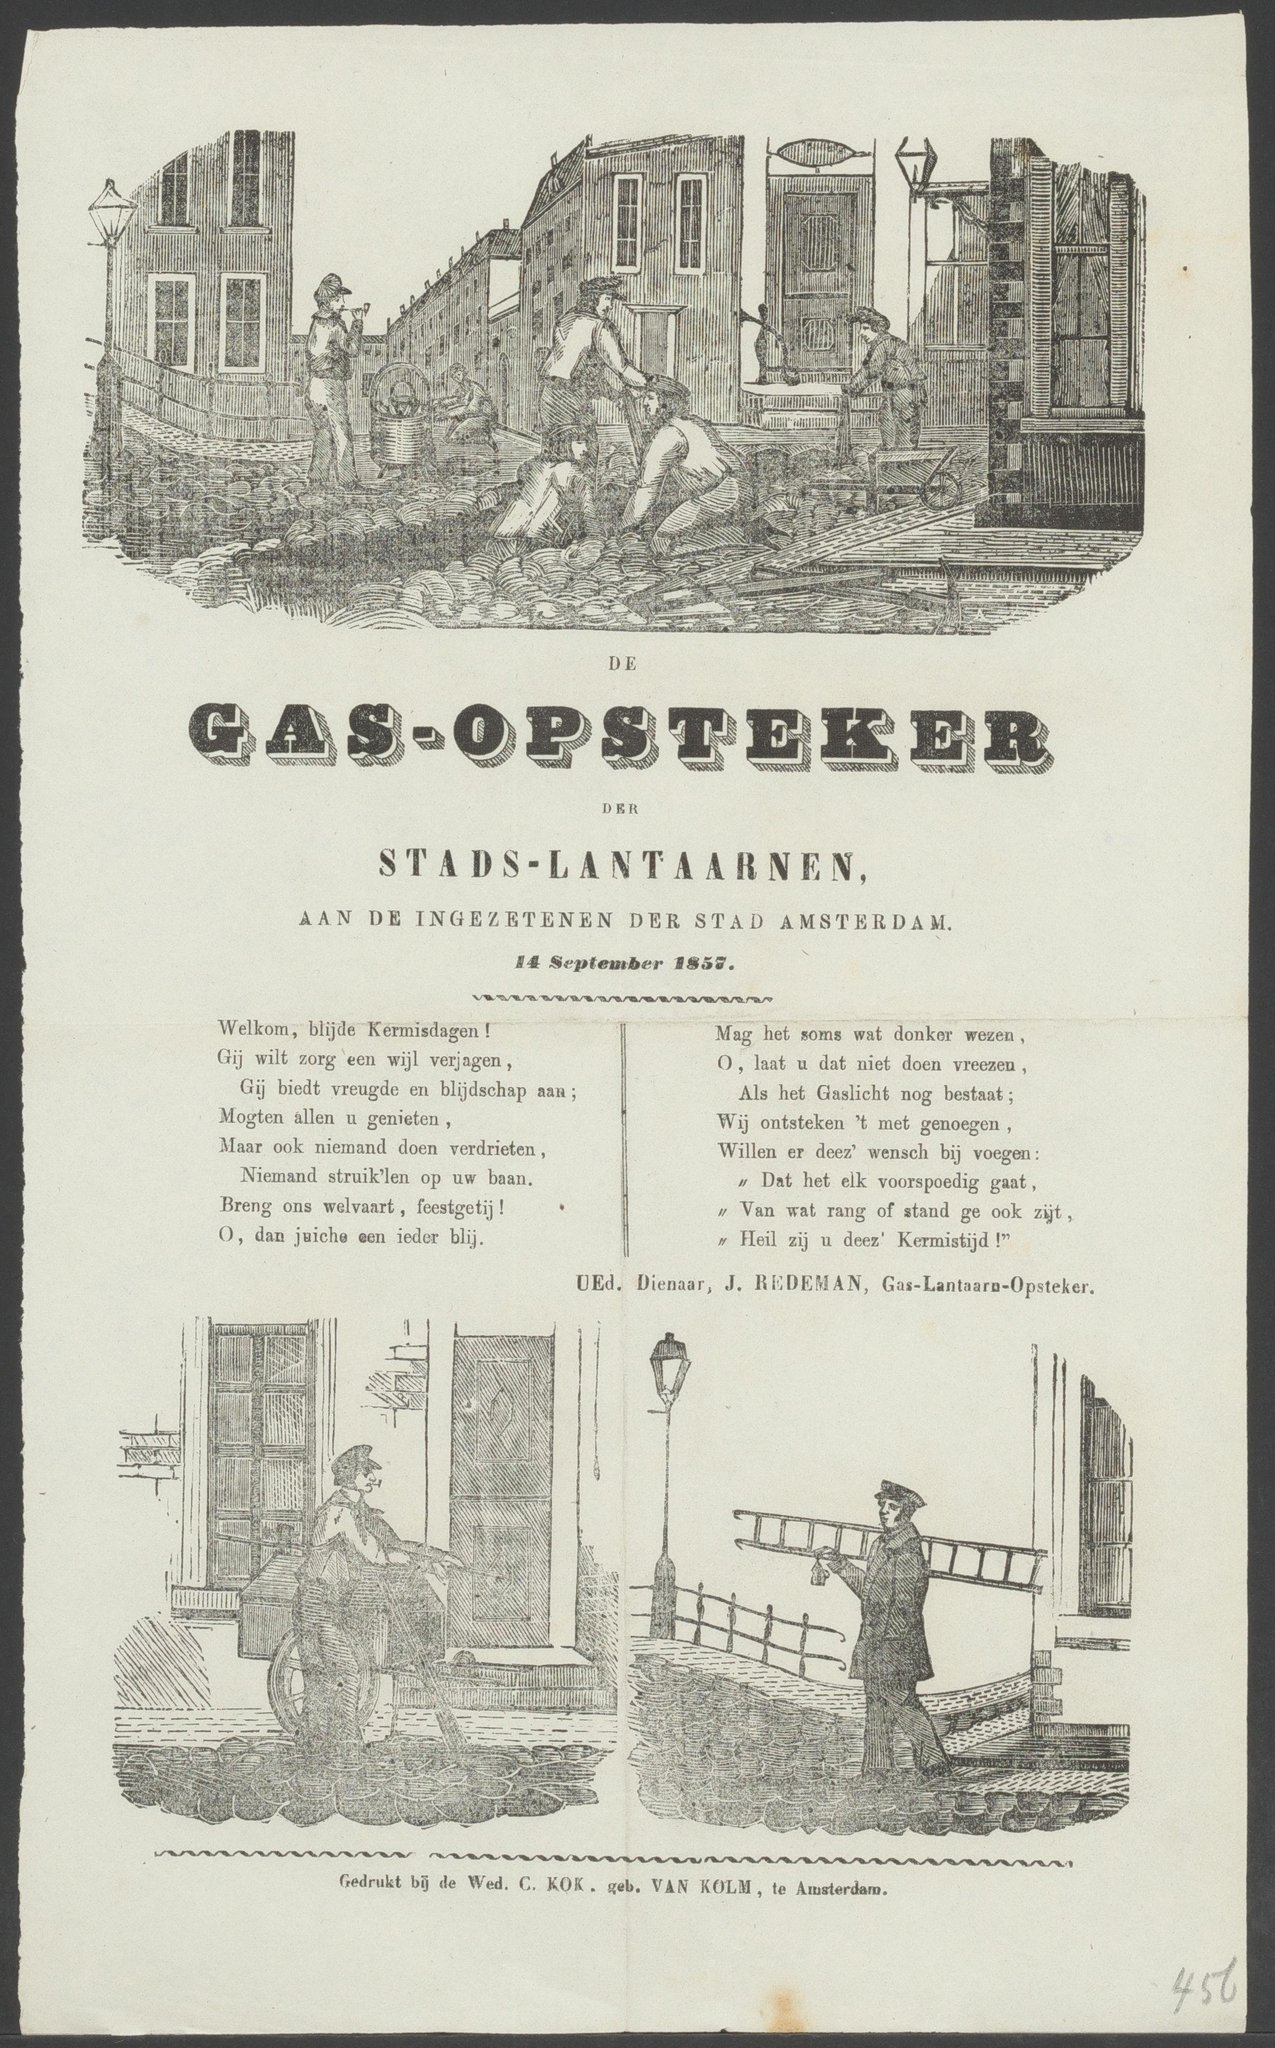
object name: print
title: Kermiswens van de gaslantaarnopstekers van Amsterdam voor het jaar 1857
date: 1857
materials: paper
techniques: letterpress printing, engraving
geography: amsterdam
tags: gas-lamp, gas supply, digging (industrial process), street lighting, amsterdam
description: Kermiswens van de Amsterdamse gaslantaarnopstekers voor het jaar 1857. Centraal een vers in twee kolommen. Bovenaan een straat in Amsterdam opgebroken voor de aanleg van de gasleiding. Onderaan twee gasfitters. Van de gaslantaarnopsteker: J. Redeman. Onderwerpsrubrieken binnen de Atlas Zeden en Gewoonten: Zeden en gewoonten in engeren zin, Volksleven, Volksbladen, Nieuwjaars- en Kerstwenschen, Amsterdam.